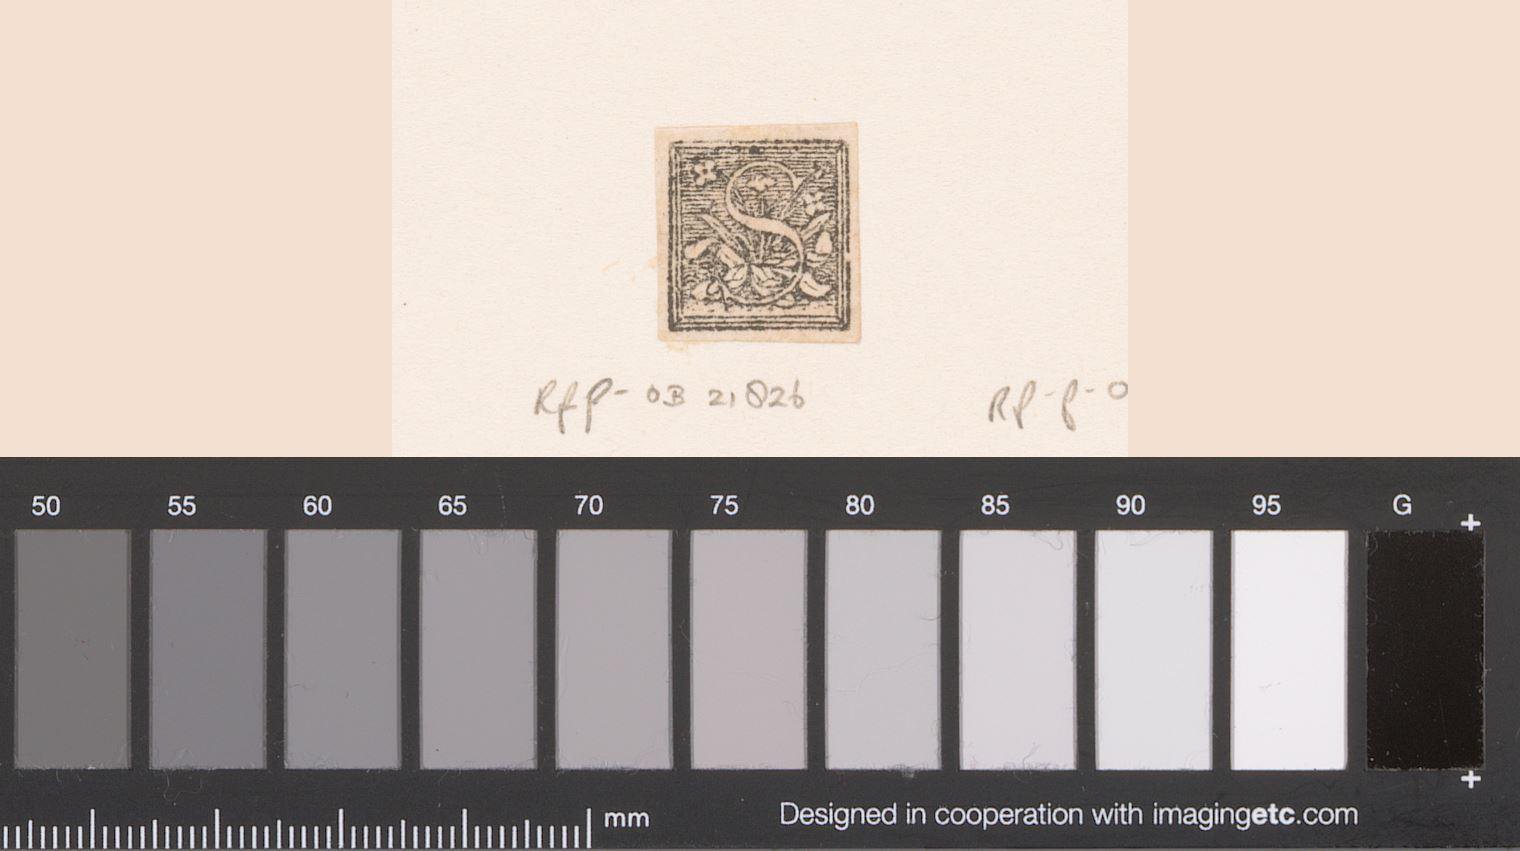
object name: print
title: Versierde initialen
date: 1556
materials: paper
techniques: letterpress printing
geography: zurich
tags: initial, ornament derived from plant forms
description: Prent afkomstig uit: Bibel, die gantze, das ist alle Bücher alts und news Testaments (...). Zürich: Johann Froschauer, 1556.